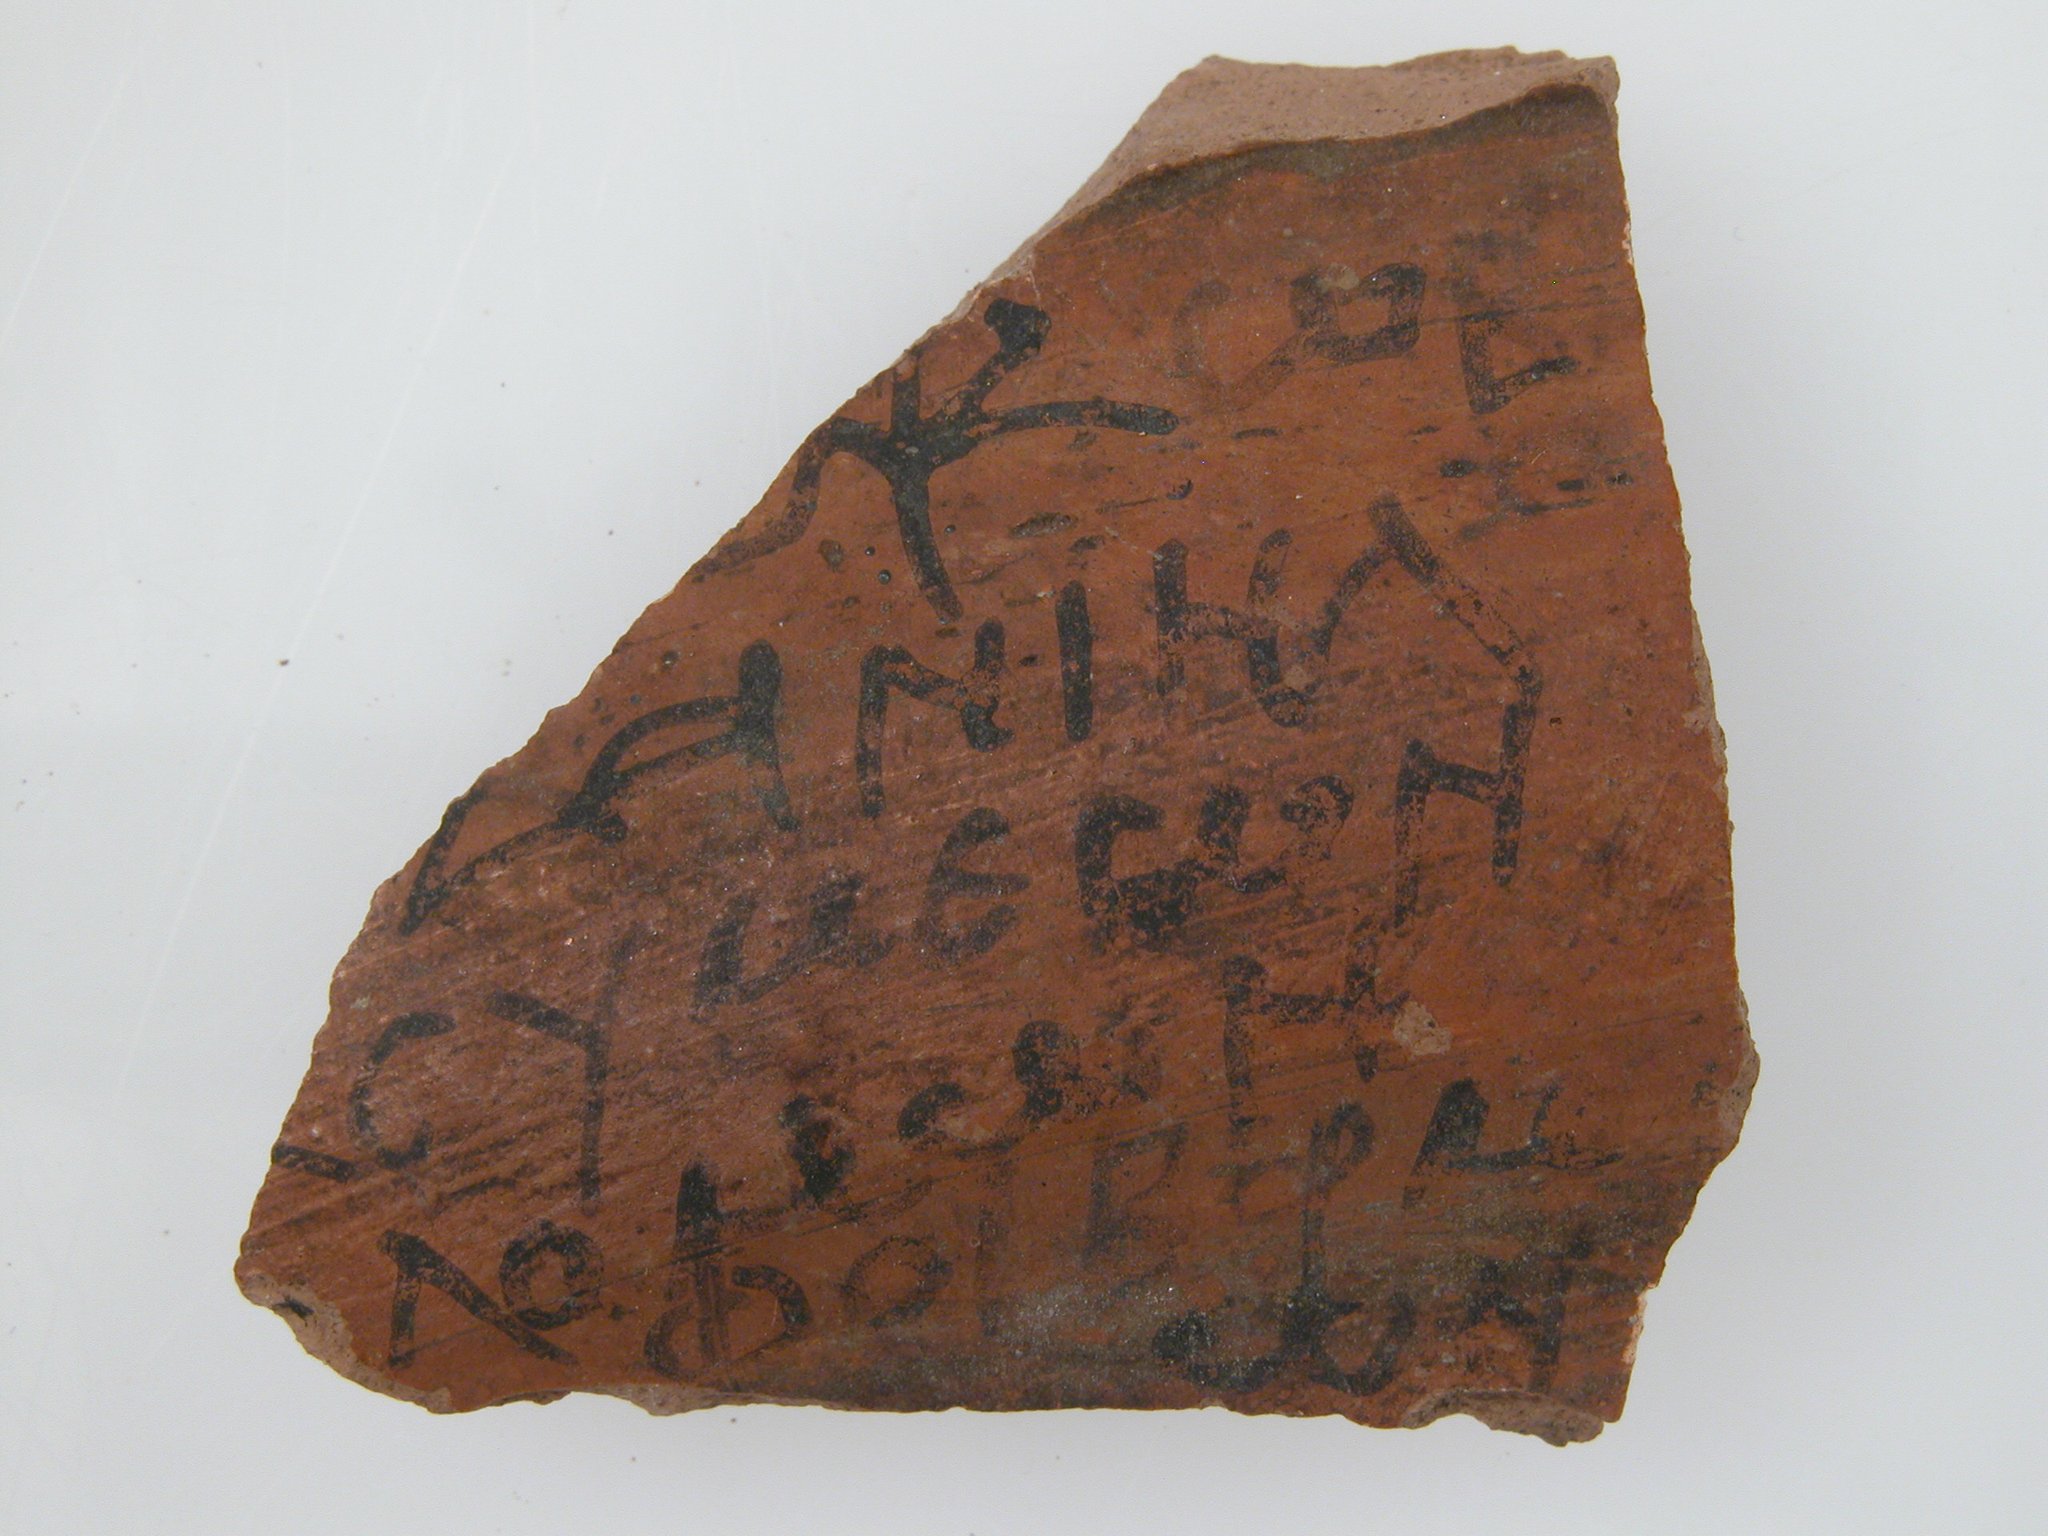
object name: ostrakon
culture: coptic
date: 580-640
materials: ink, pottery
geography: egypt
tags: coptic,documents